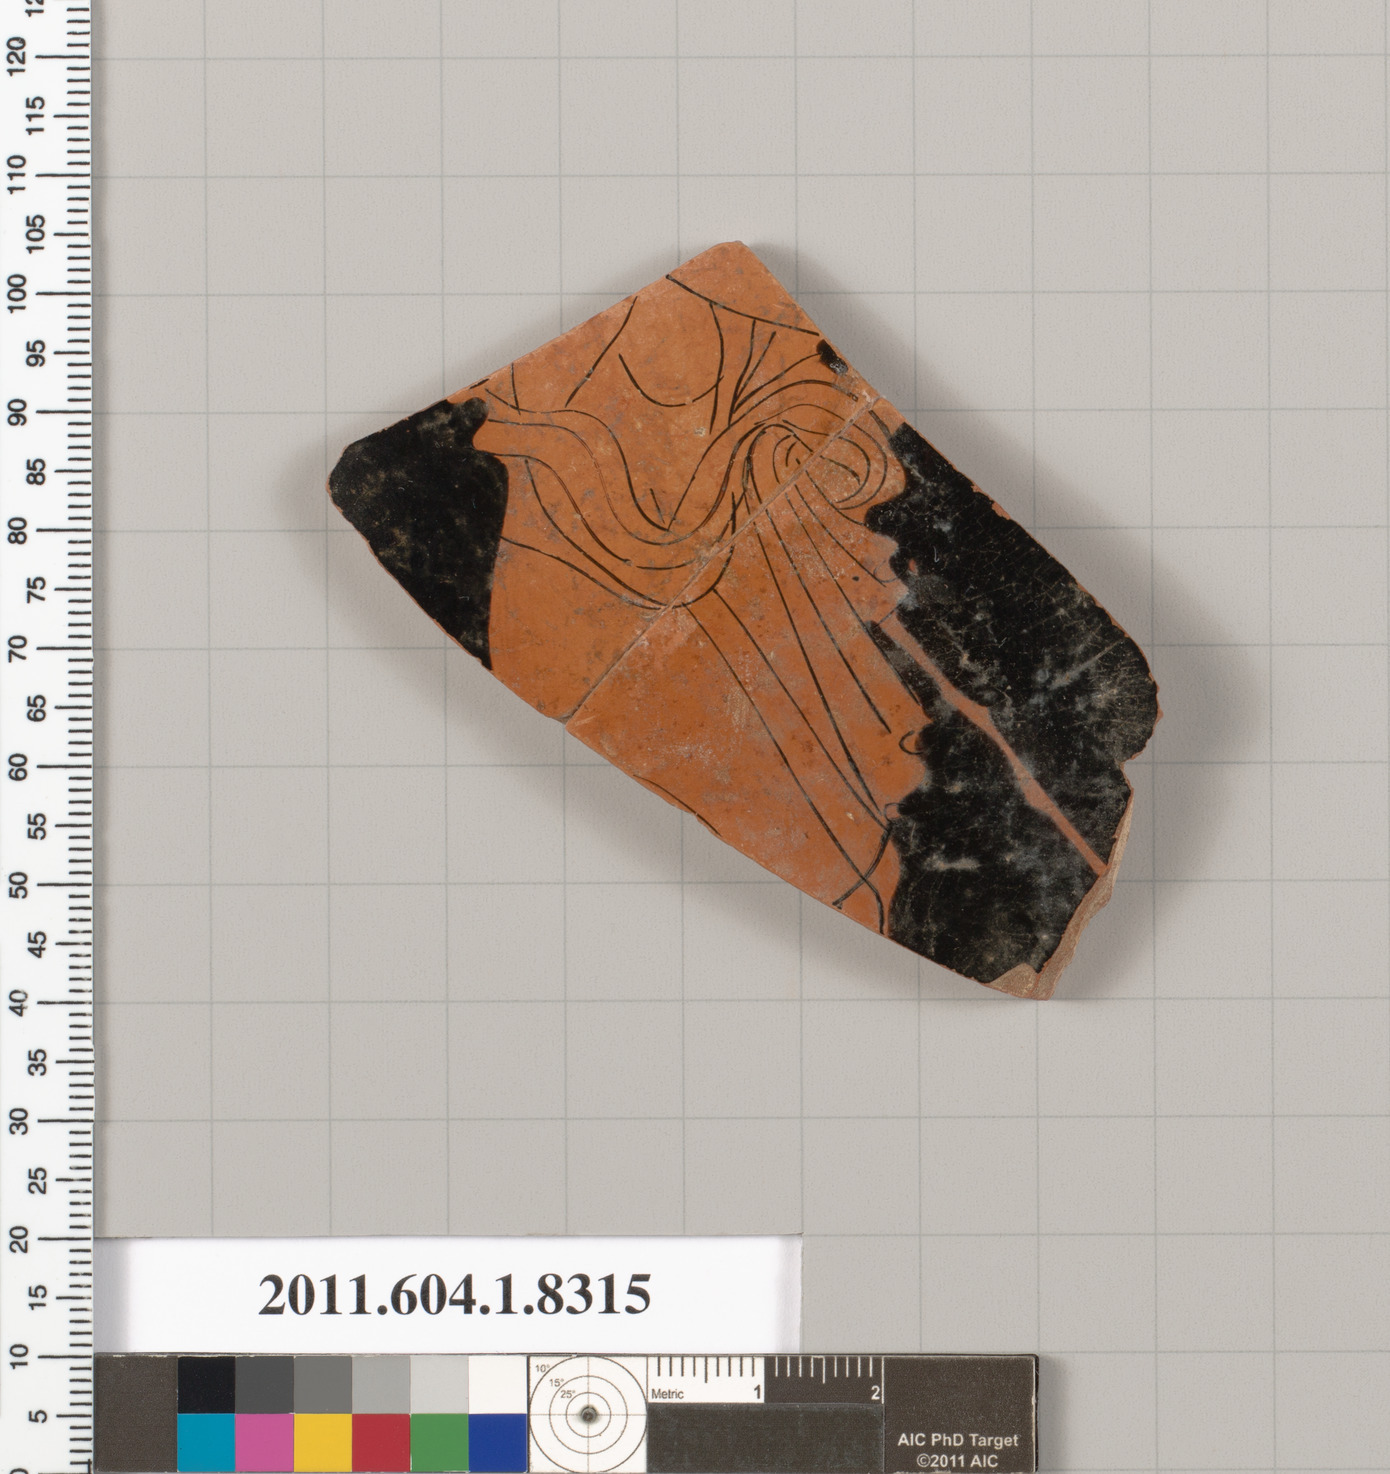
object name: kylix fragment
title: Terracotta fragment of a kylix (drinking cup)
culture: greek, attic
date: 475-451 BCE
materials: terracotta